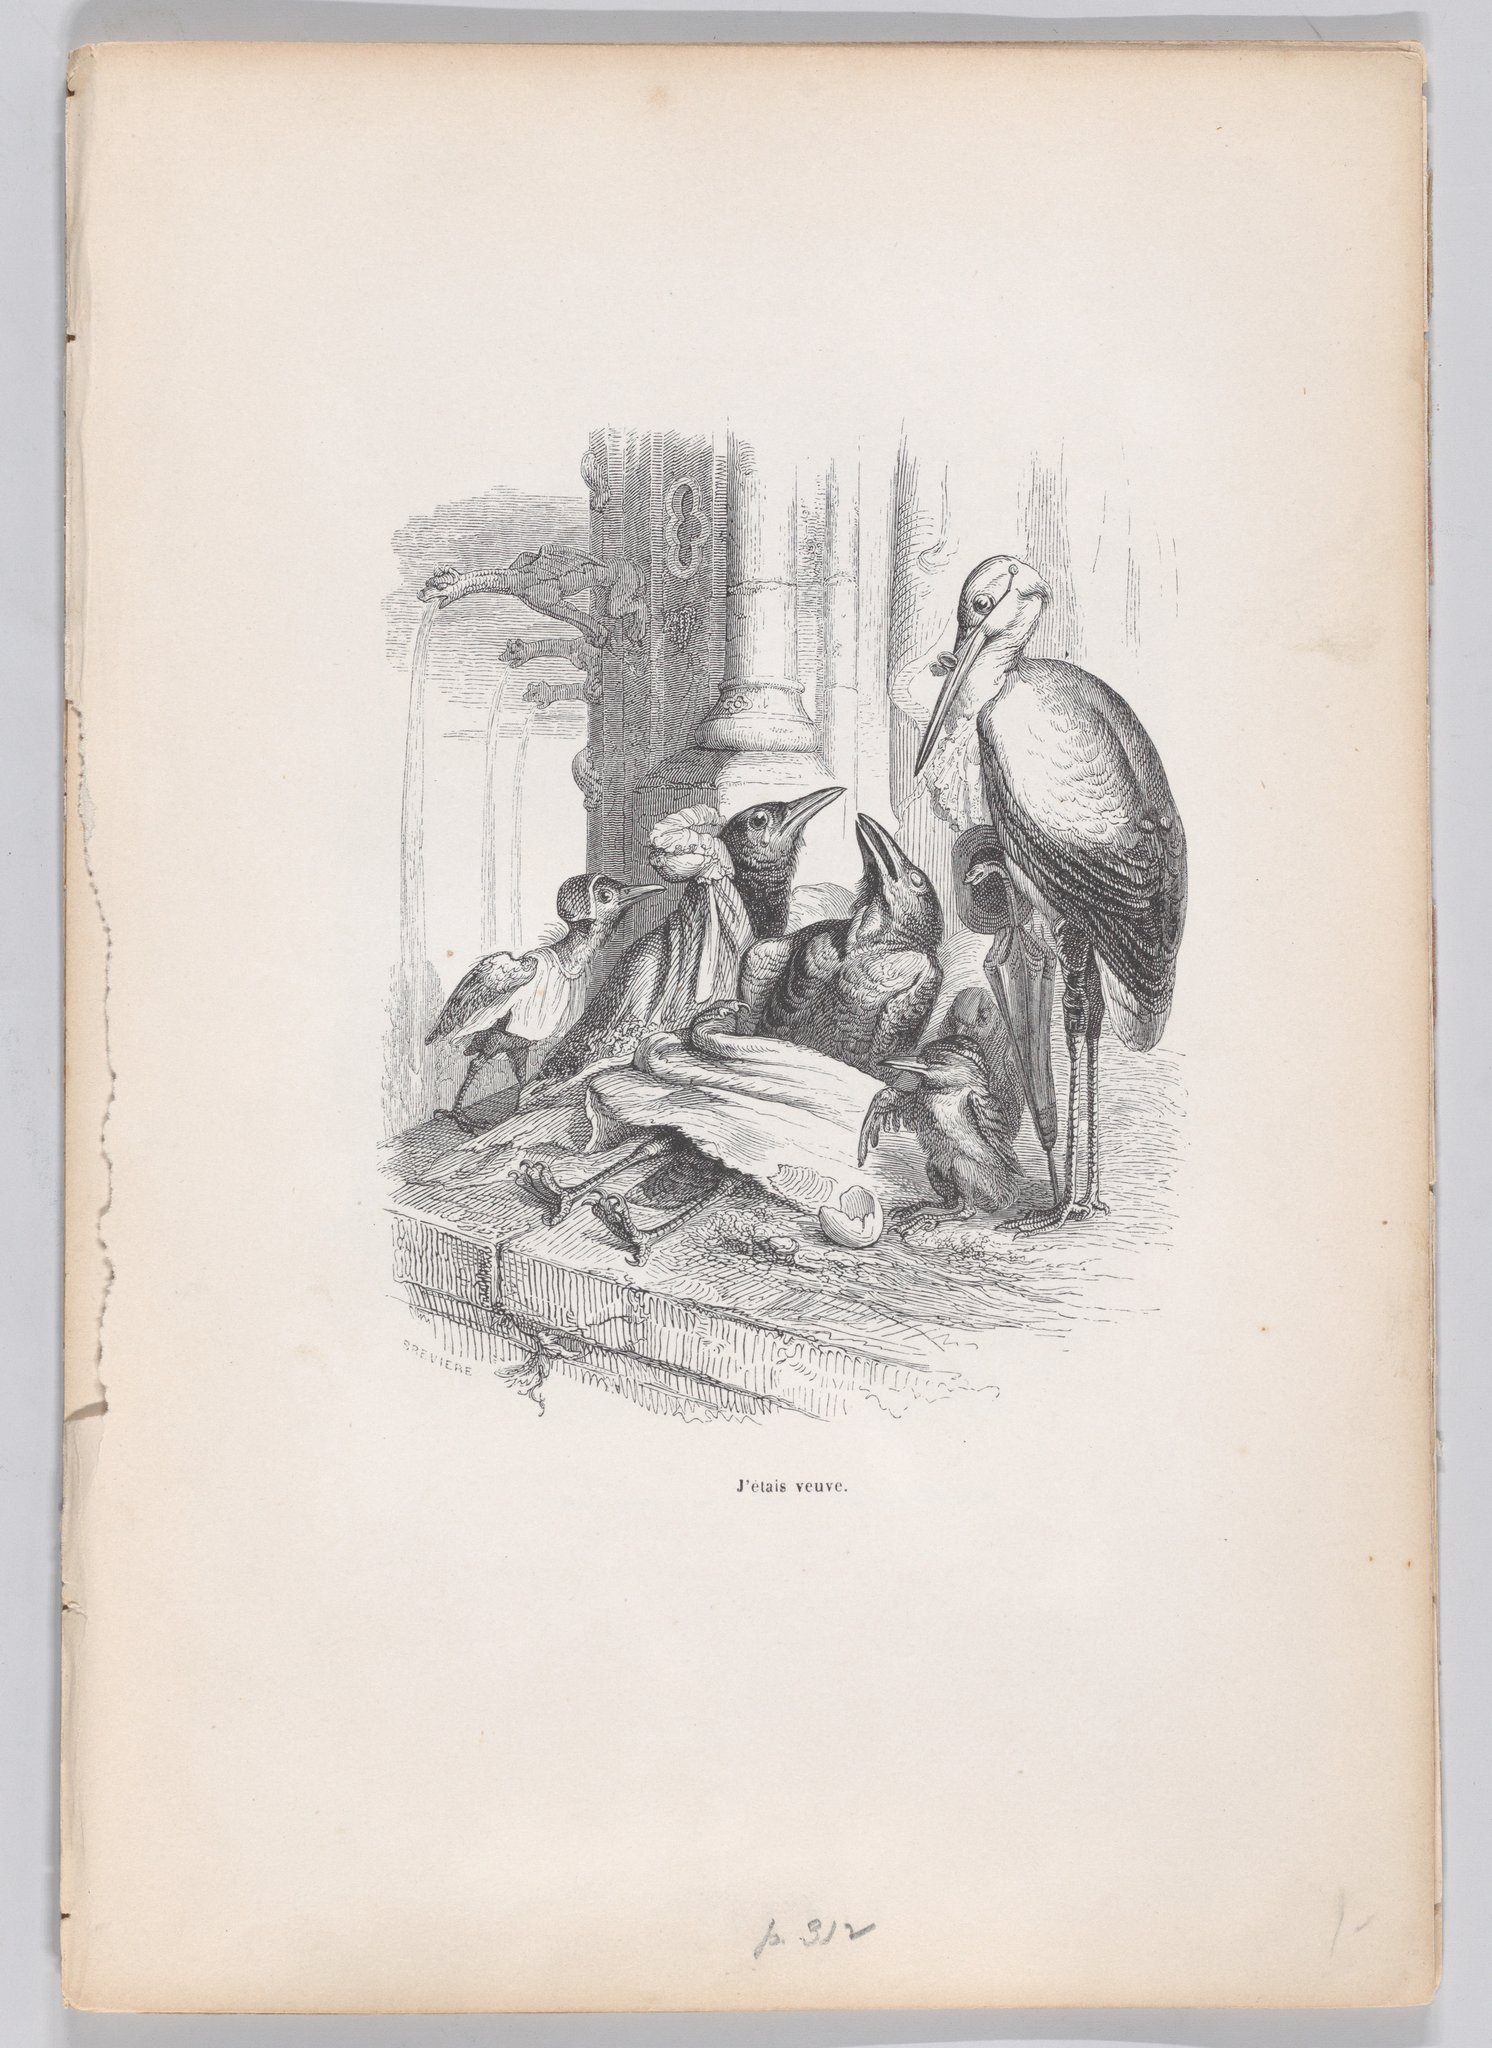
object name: print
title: I was a widow, from "Scenes from the Private and Public Life of Animals"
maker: j. j. grandville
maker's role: illustrator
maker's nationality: french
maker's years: 1803-1847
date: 1837-1847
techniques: engraving